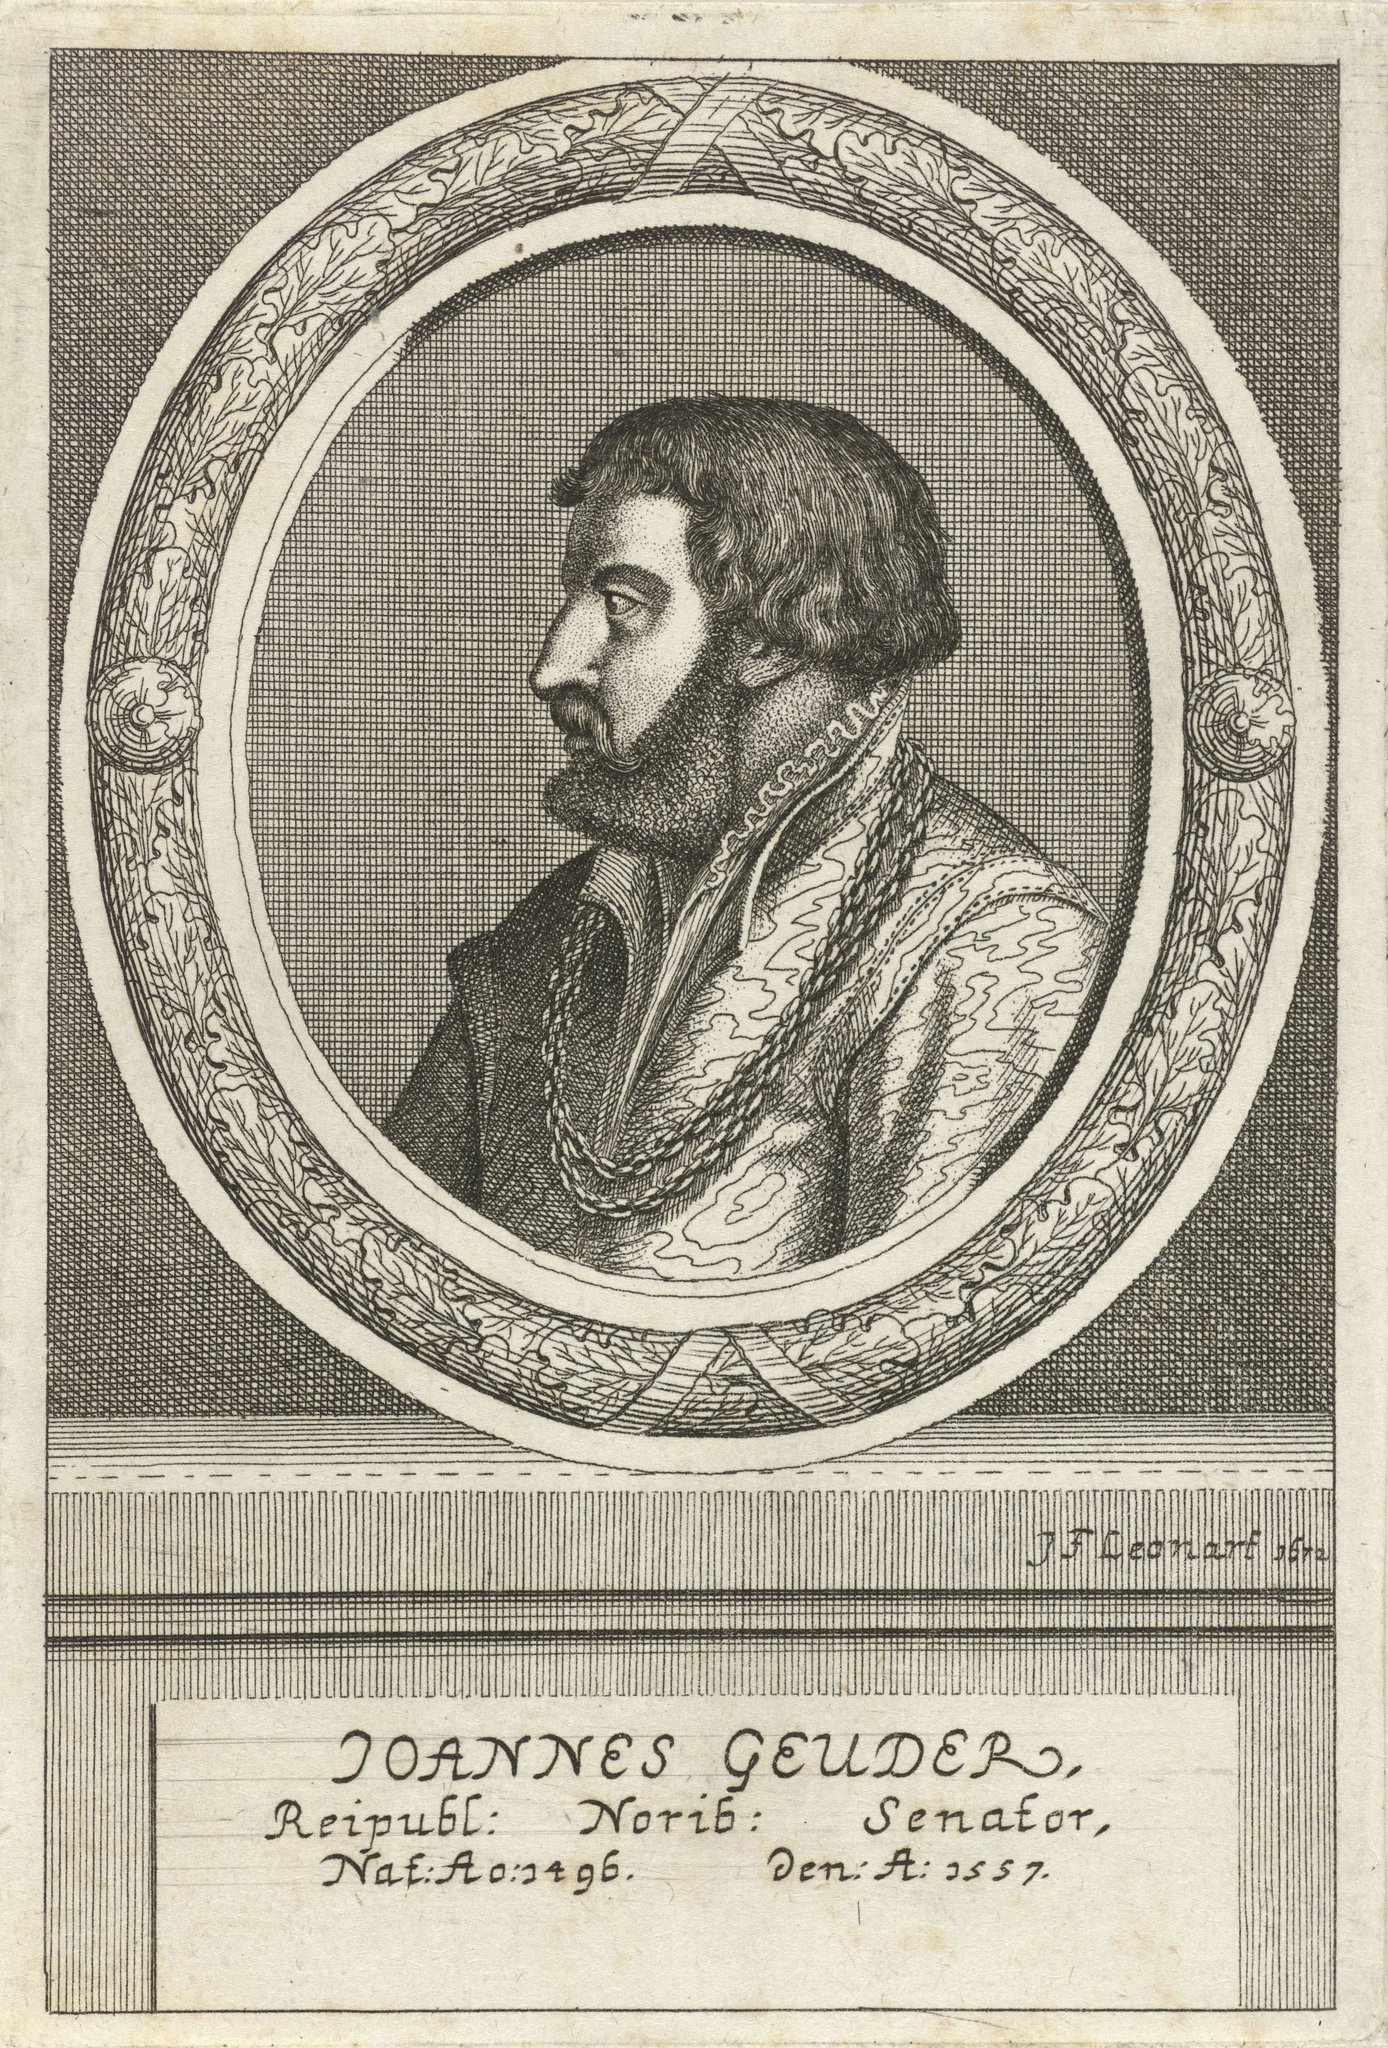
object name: print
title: Portret van Joannes Geuder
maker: johann friedrich leonard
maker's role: print maker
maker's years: 1633-1680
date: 1672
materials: paper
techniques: engraving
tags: senator, joannes geuder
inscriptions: collector's mark: Lugt 1337, collector's mark: Lugt 2228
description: Portret van Joannes Geuder, senator te Neurenberg.